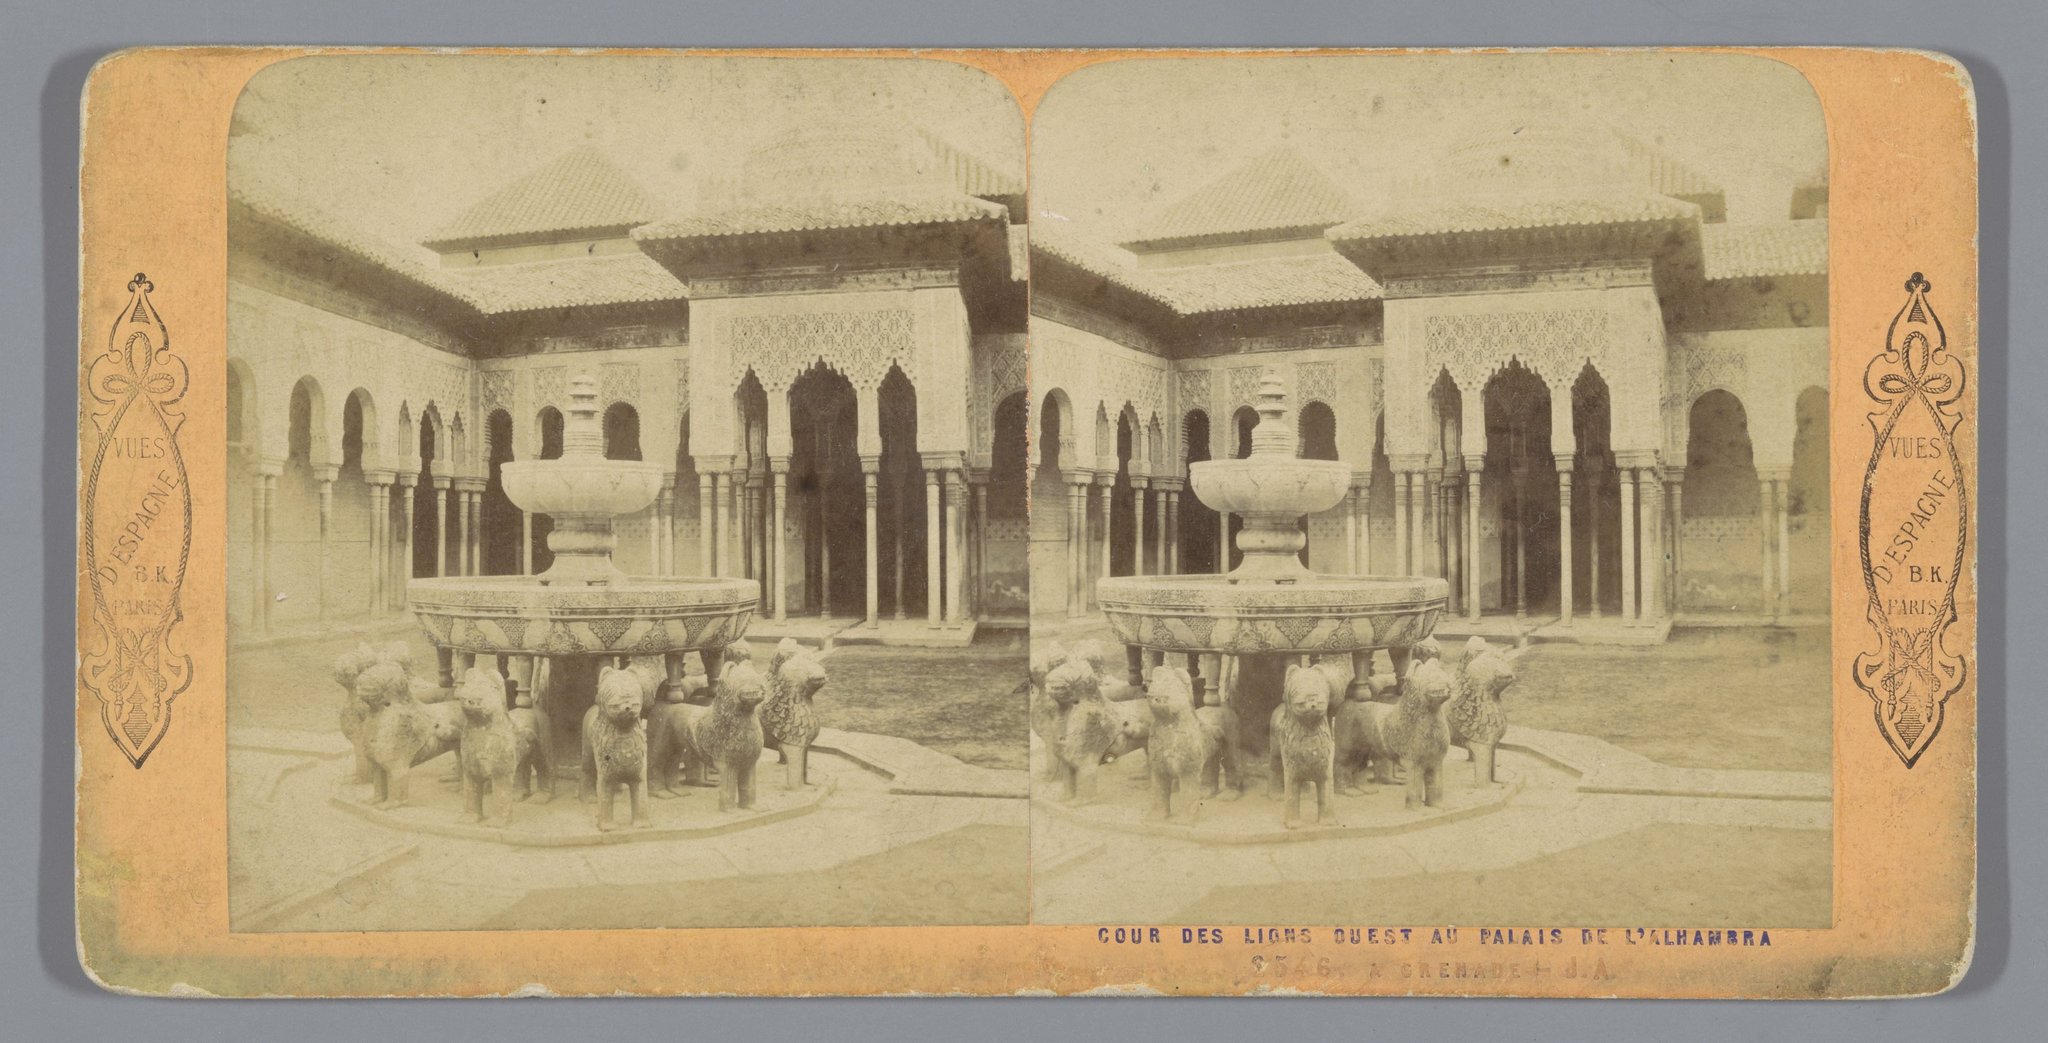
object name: stereograph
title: Cour des lions ouest au Palais de l'Alhambra a Grenade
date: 1872-1876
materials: cardboard, photographic support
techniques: albumen print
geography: alhambra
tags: inner court of palace or 'hôtel'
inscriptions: number: ‘2546.’, inscription: ‘Vues d'Espagne’